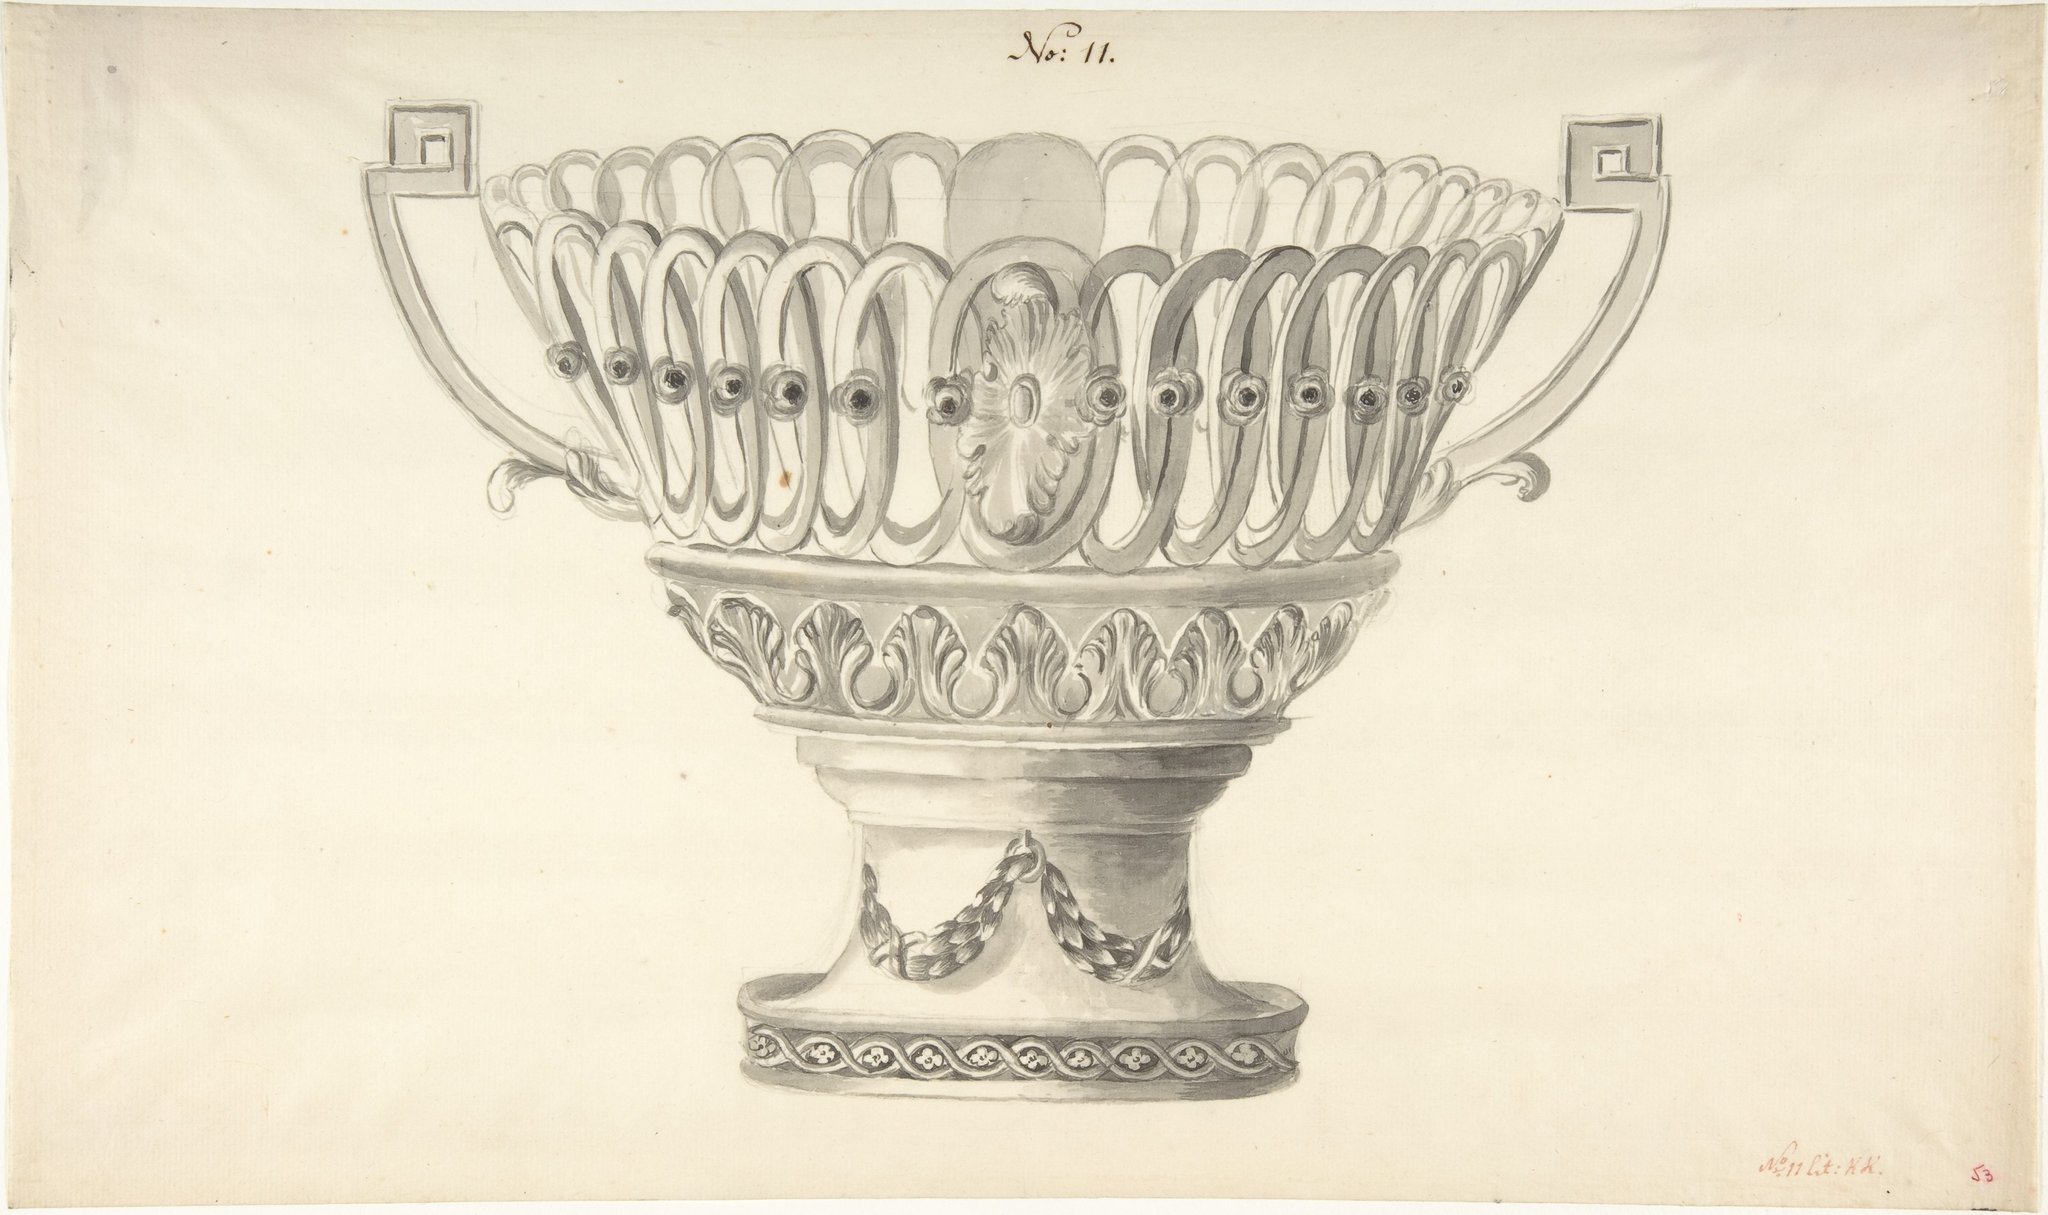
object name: drawing ornament architecture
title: Design for a Bowl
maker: anonymous, french, 18th century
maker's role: artist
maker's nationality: french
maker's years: 1700-1800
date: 1770-1790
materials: ink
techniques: brush, pen, wash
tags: bowls